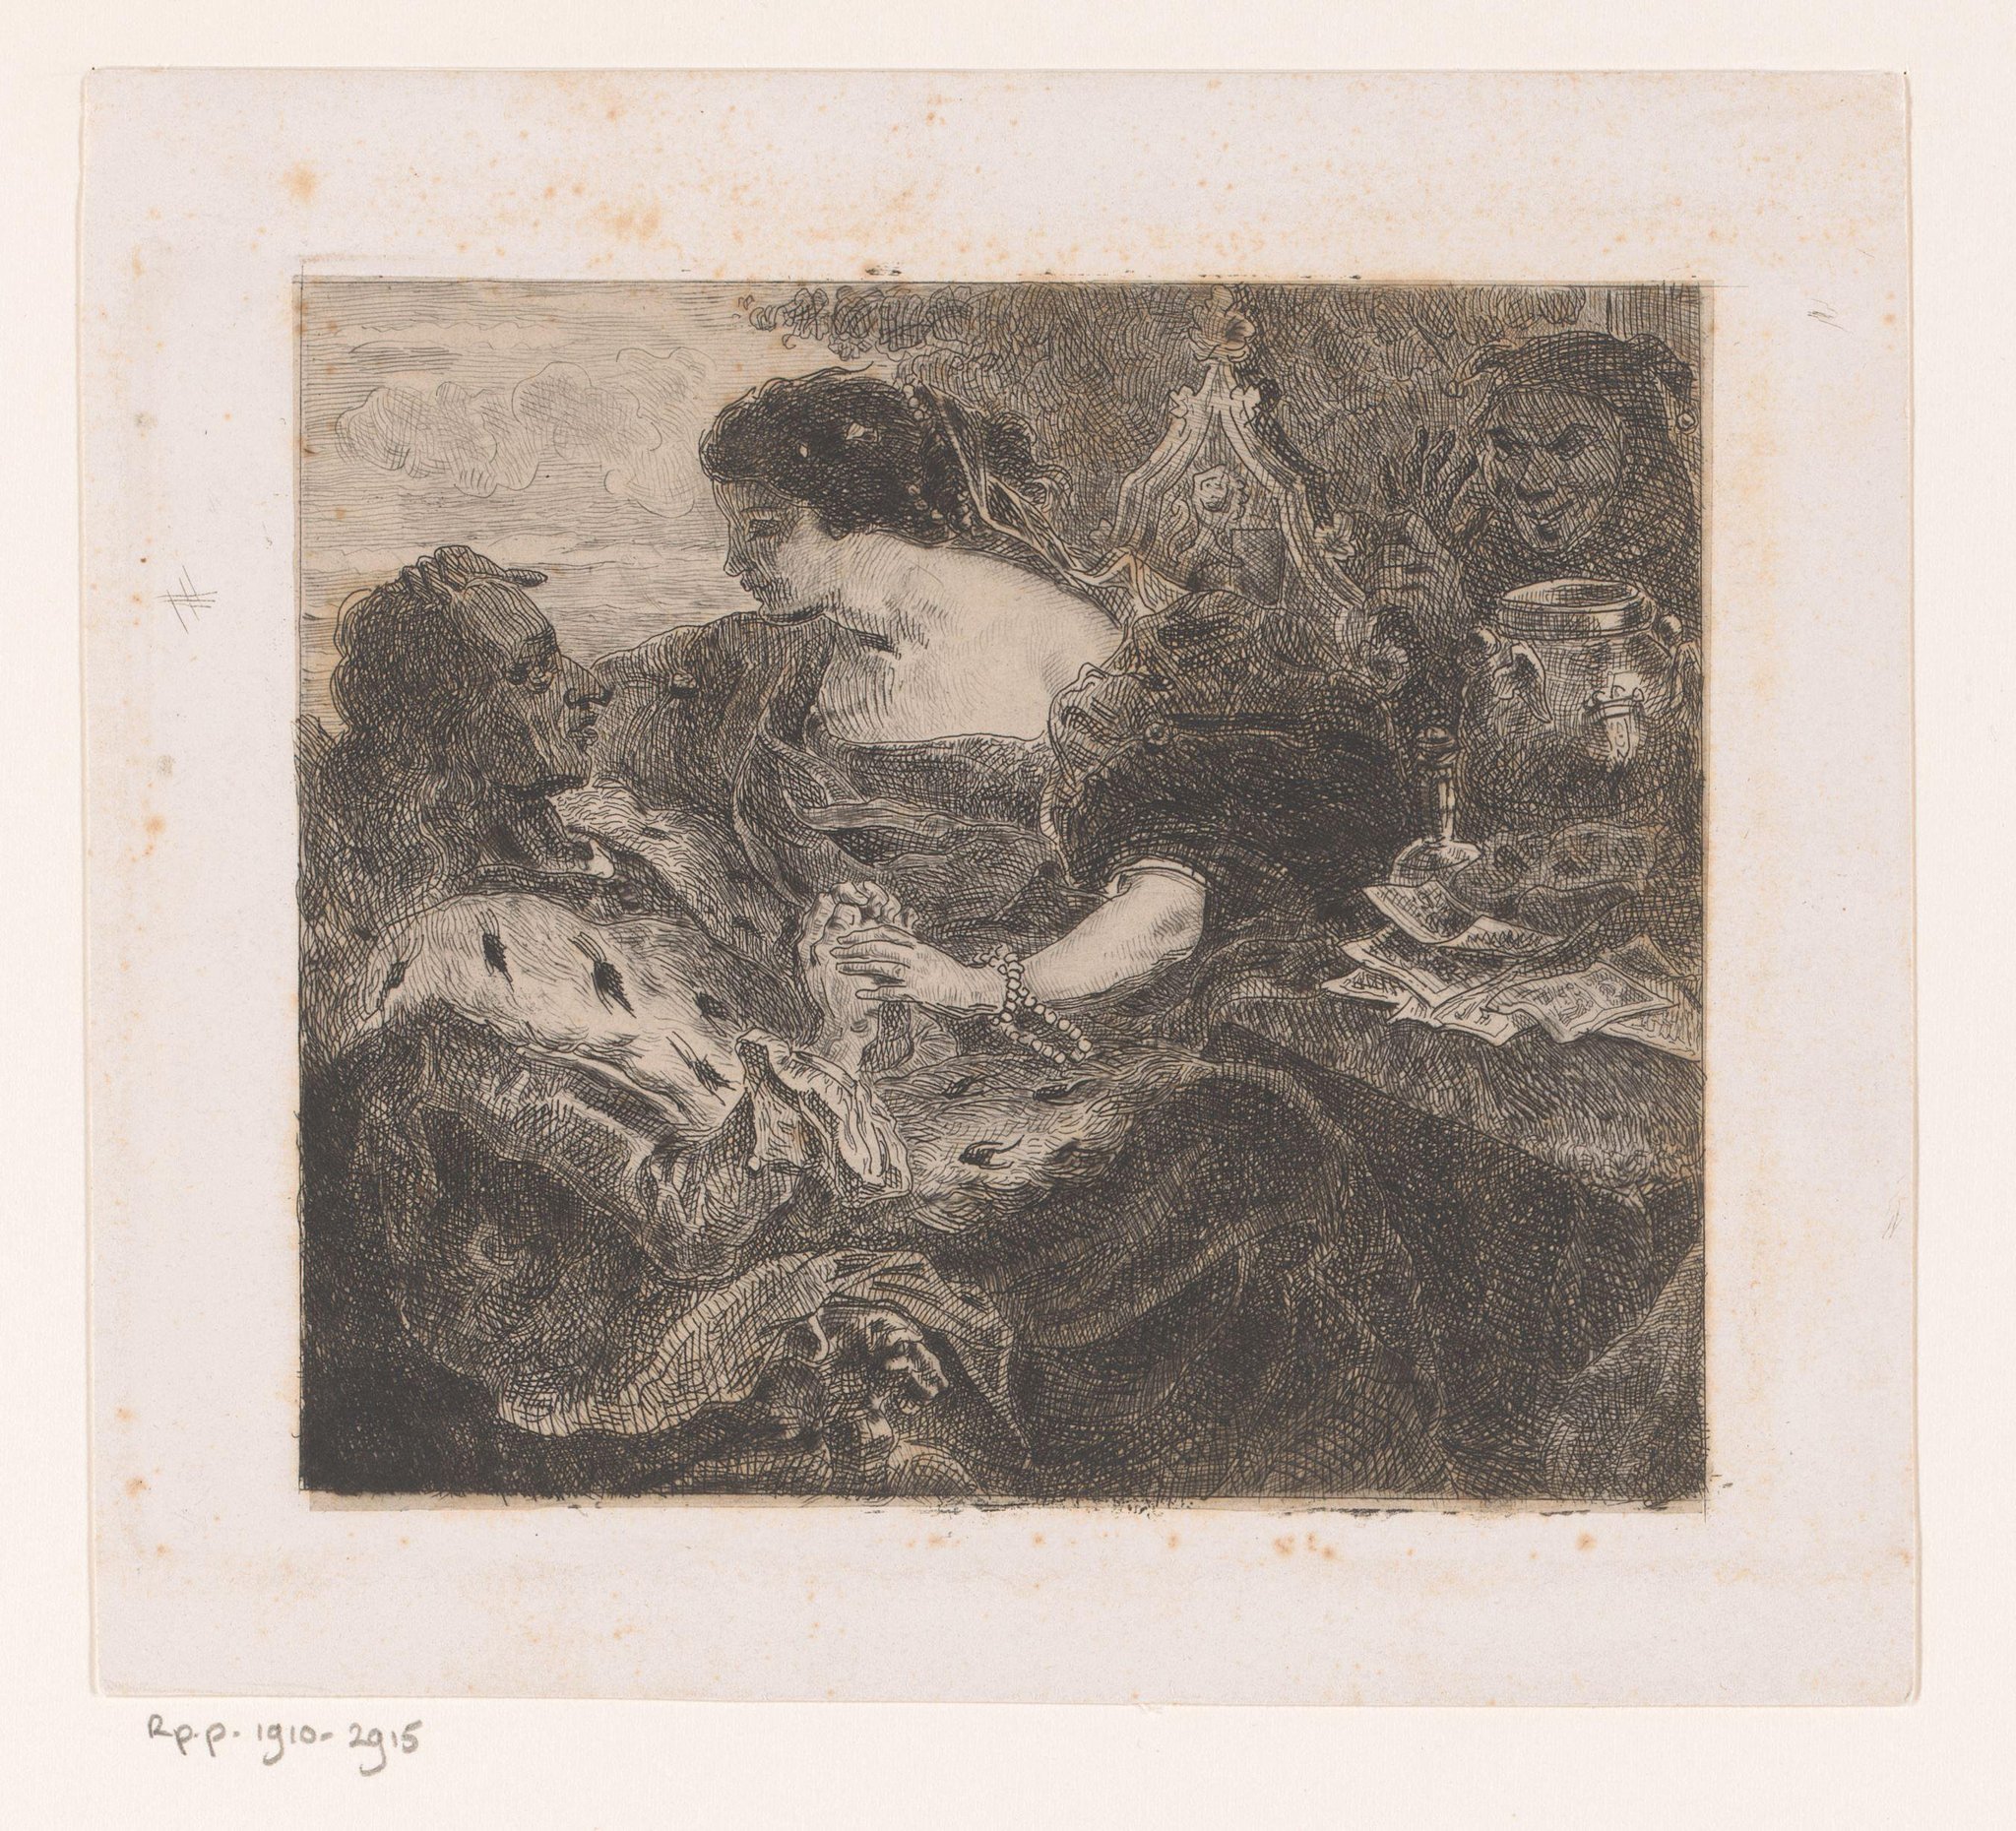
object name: print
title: Isabella aan tafel bij Karel VI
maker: jacob joseph eeckhout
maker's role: draughtsman, print maker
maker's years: 1793-1861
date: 1803-1861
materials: paper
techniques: drypoint, etching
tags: paris, queen, king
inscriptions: collector's mark: Lugt 2228, collector's mark: Lugt 1485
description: Koning Karel VI trouwde met Isabella van Beieren. De narrenfiguur in de achtergrond van deze prent symboliseert de waanbeelden die Karel VI teisterden.